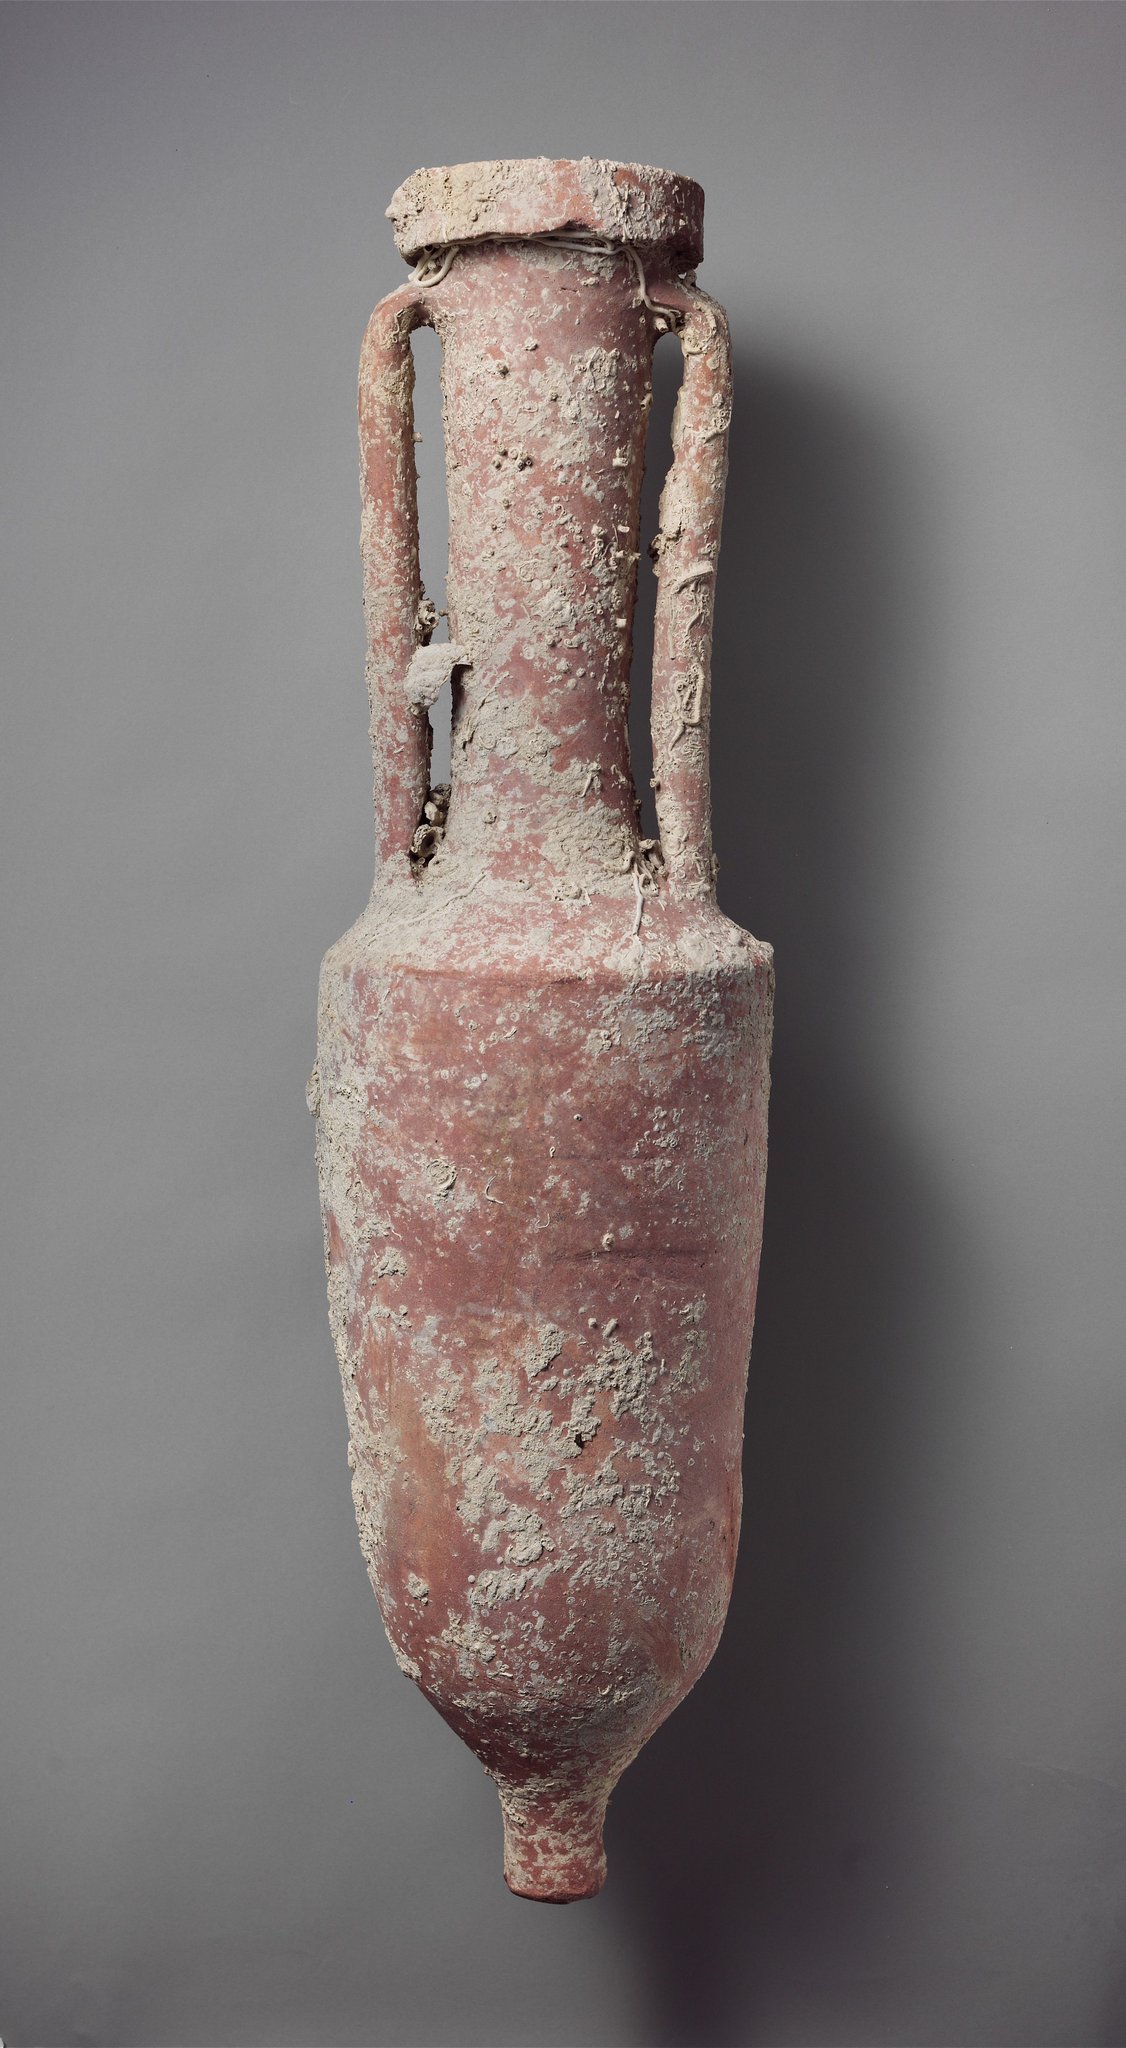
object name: amphora, pointed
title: Terracotta wine amphora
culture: roman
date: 100 BCE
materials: terracotta